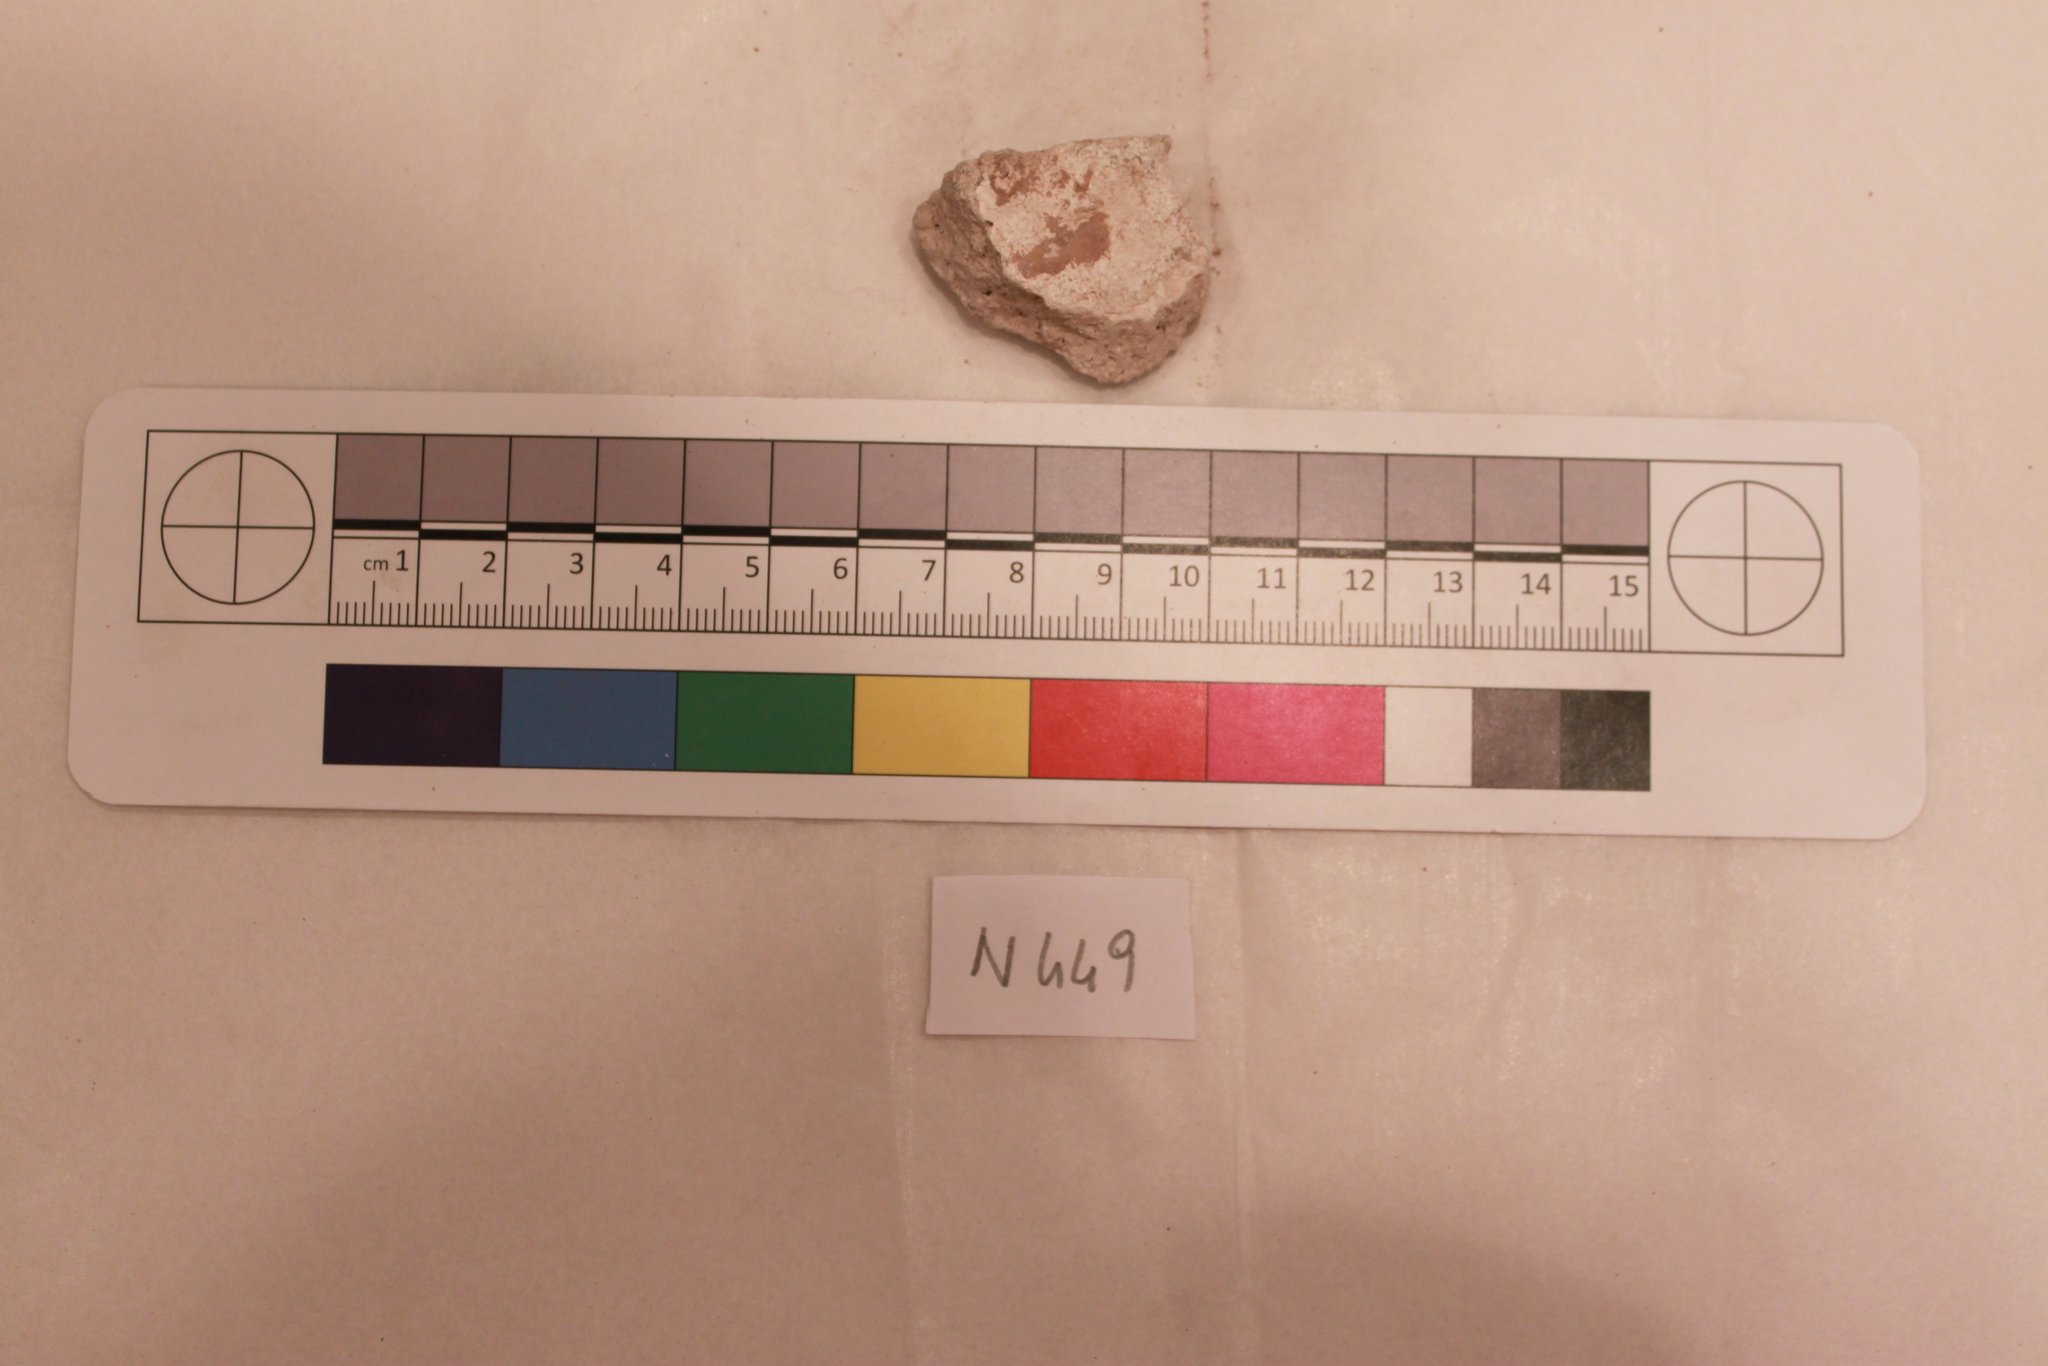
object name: fragment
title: Stucco Fragment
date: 701-1200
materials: plaster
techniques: carving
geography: iran